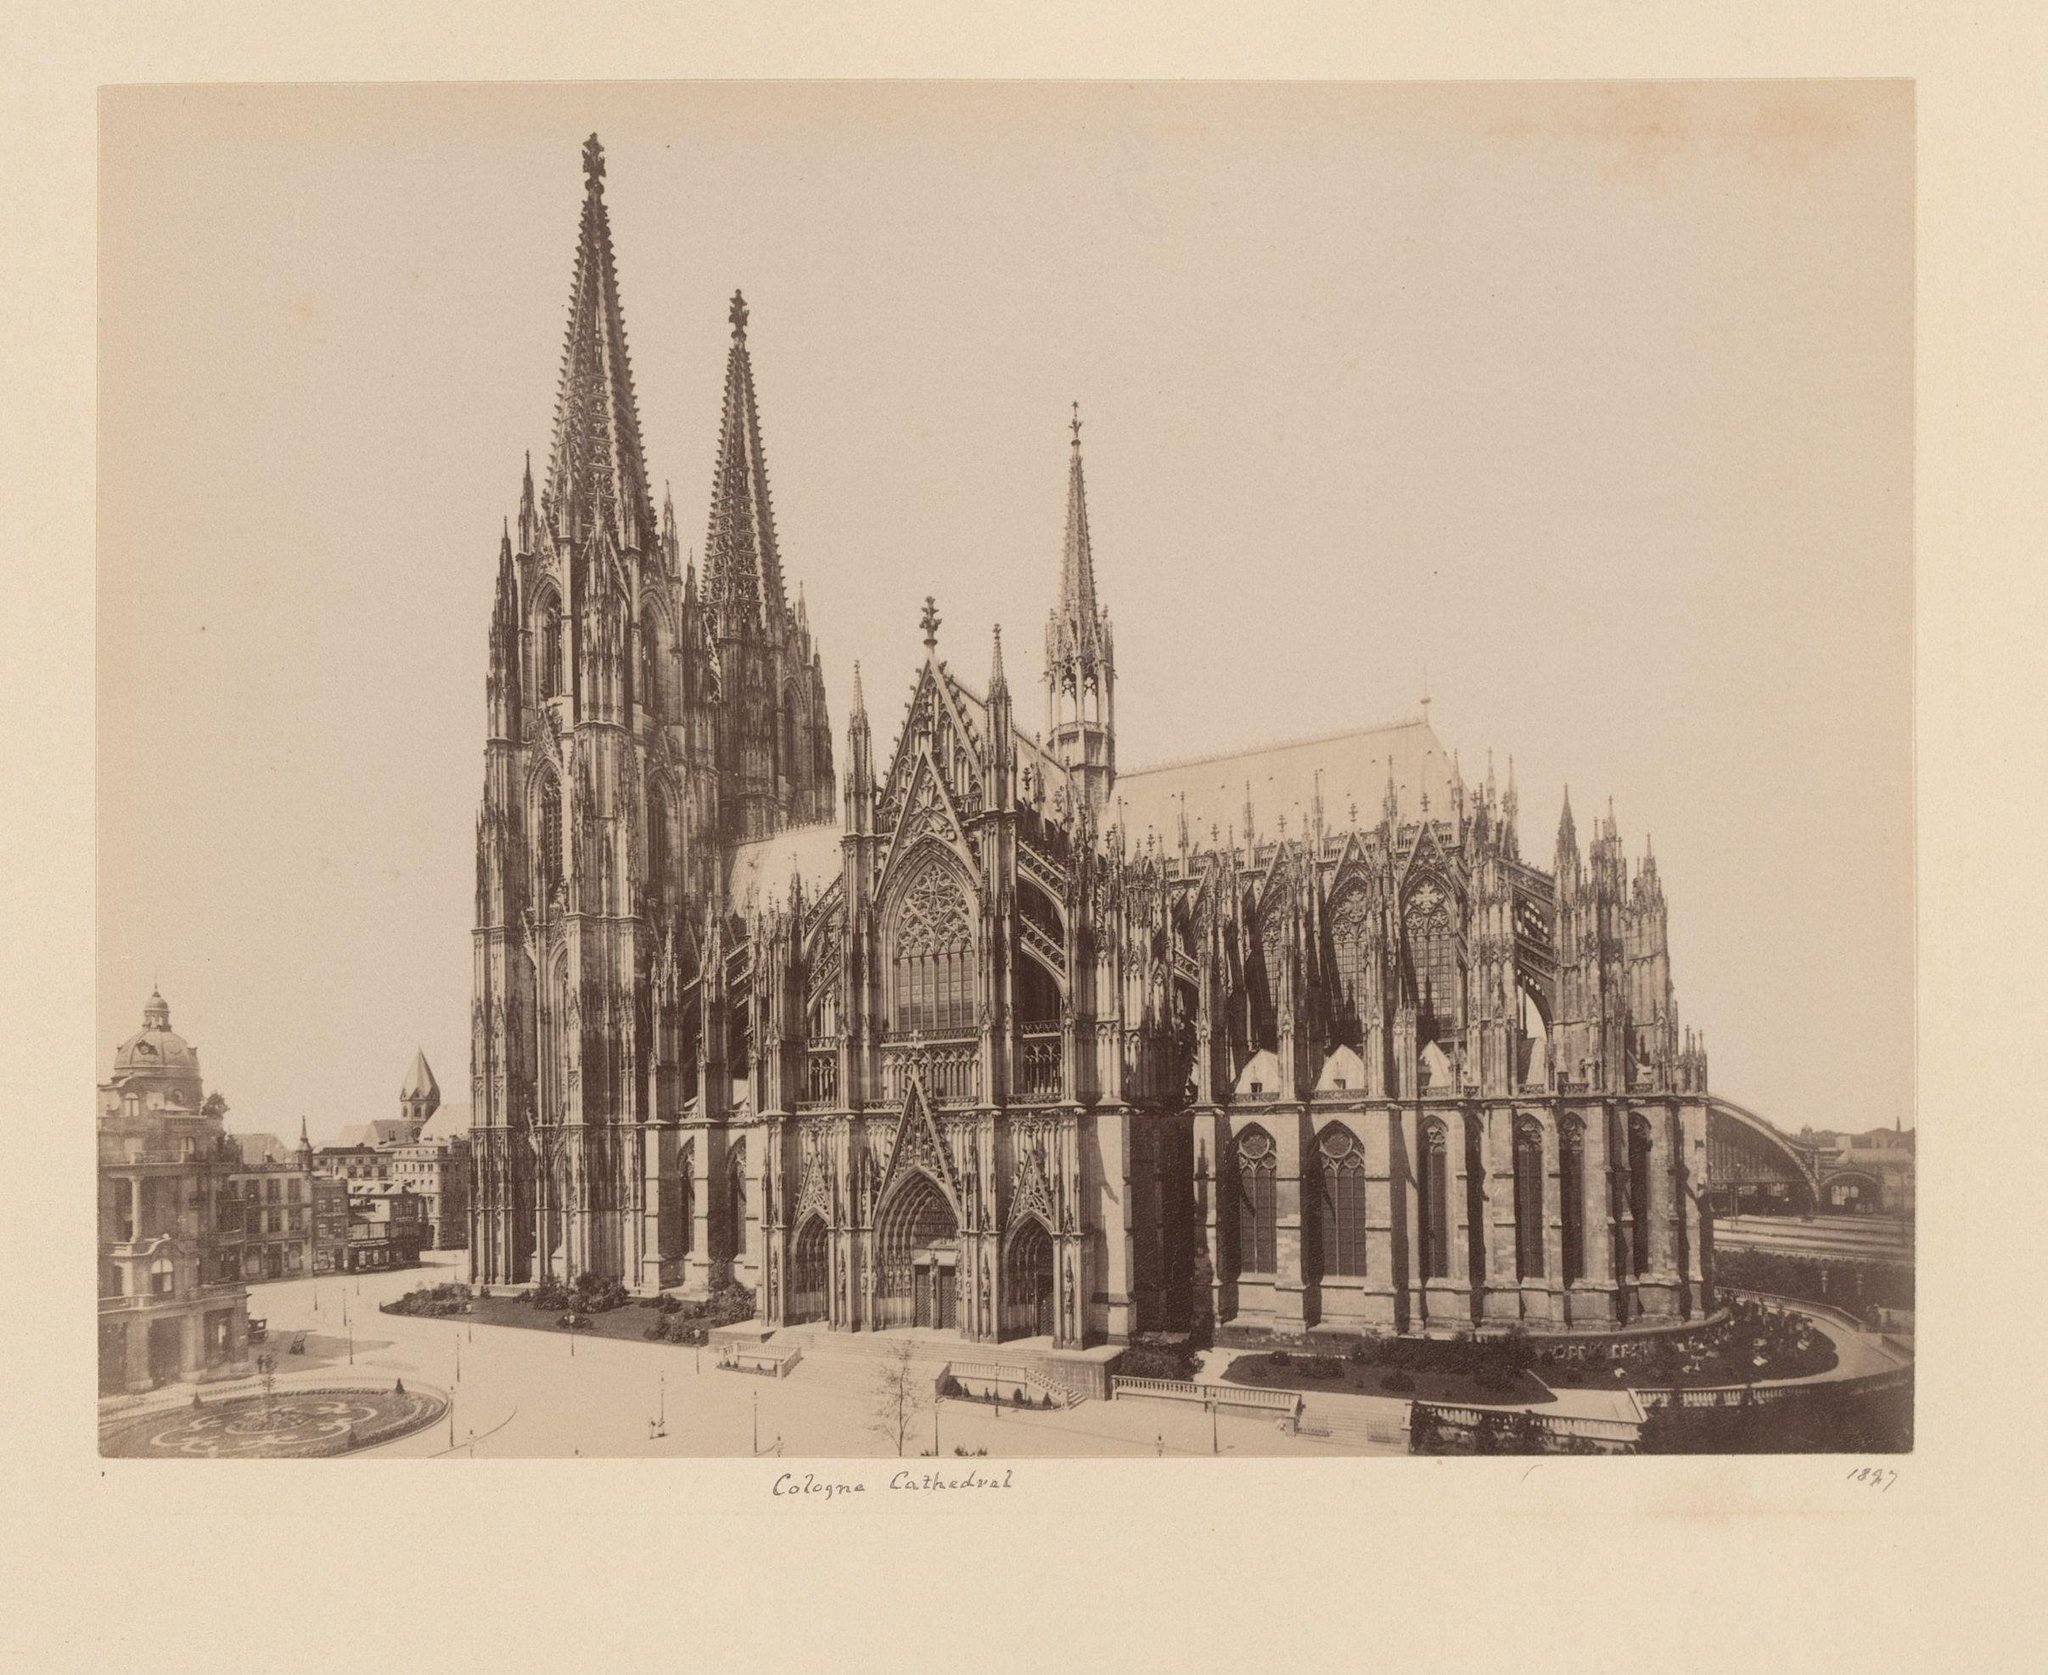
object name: album leaf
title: Gezicht op de Dom van Keulen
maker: Anonymous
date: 1897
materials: cardboard, photographic support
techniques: albumen print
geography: cologne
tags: parts of church exterior and annexes: portal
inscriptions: annotation: ‘Cologne Cathedral 1897’